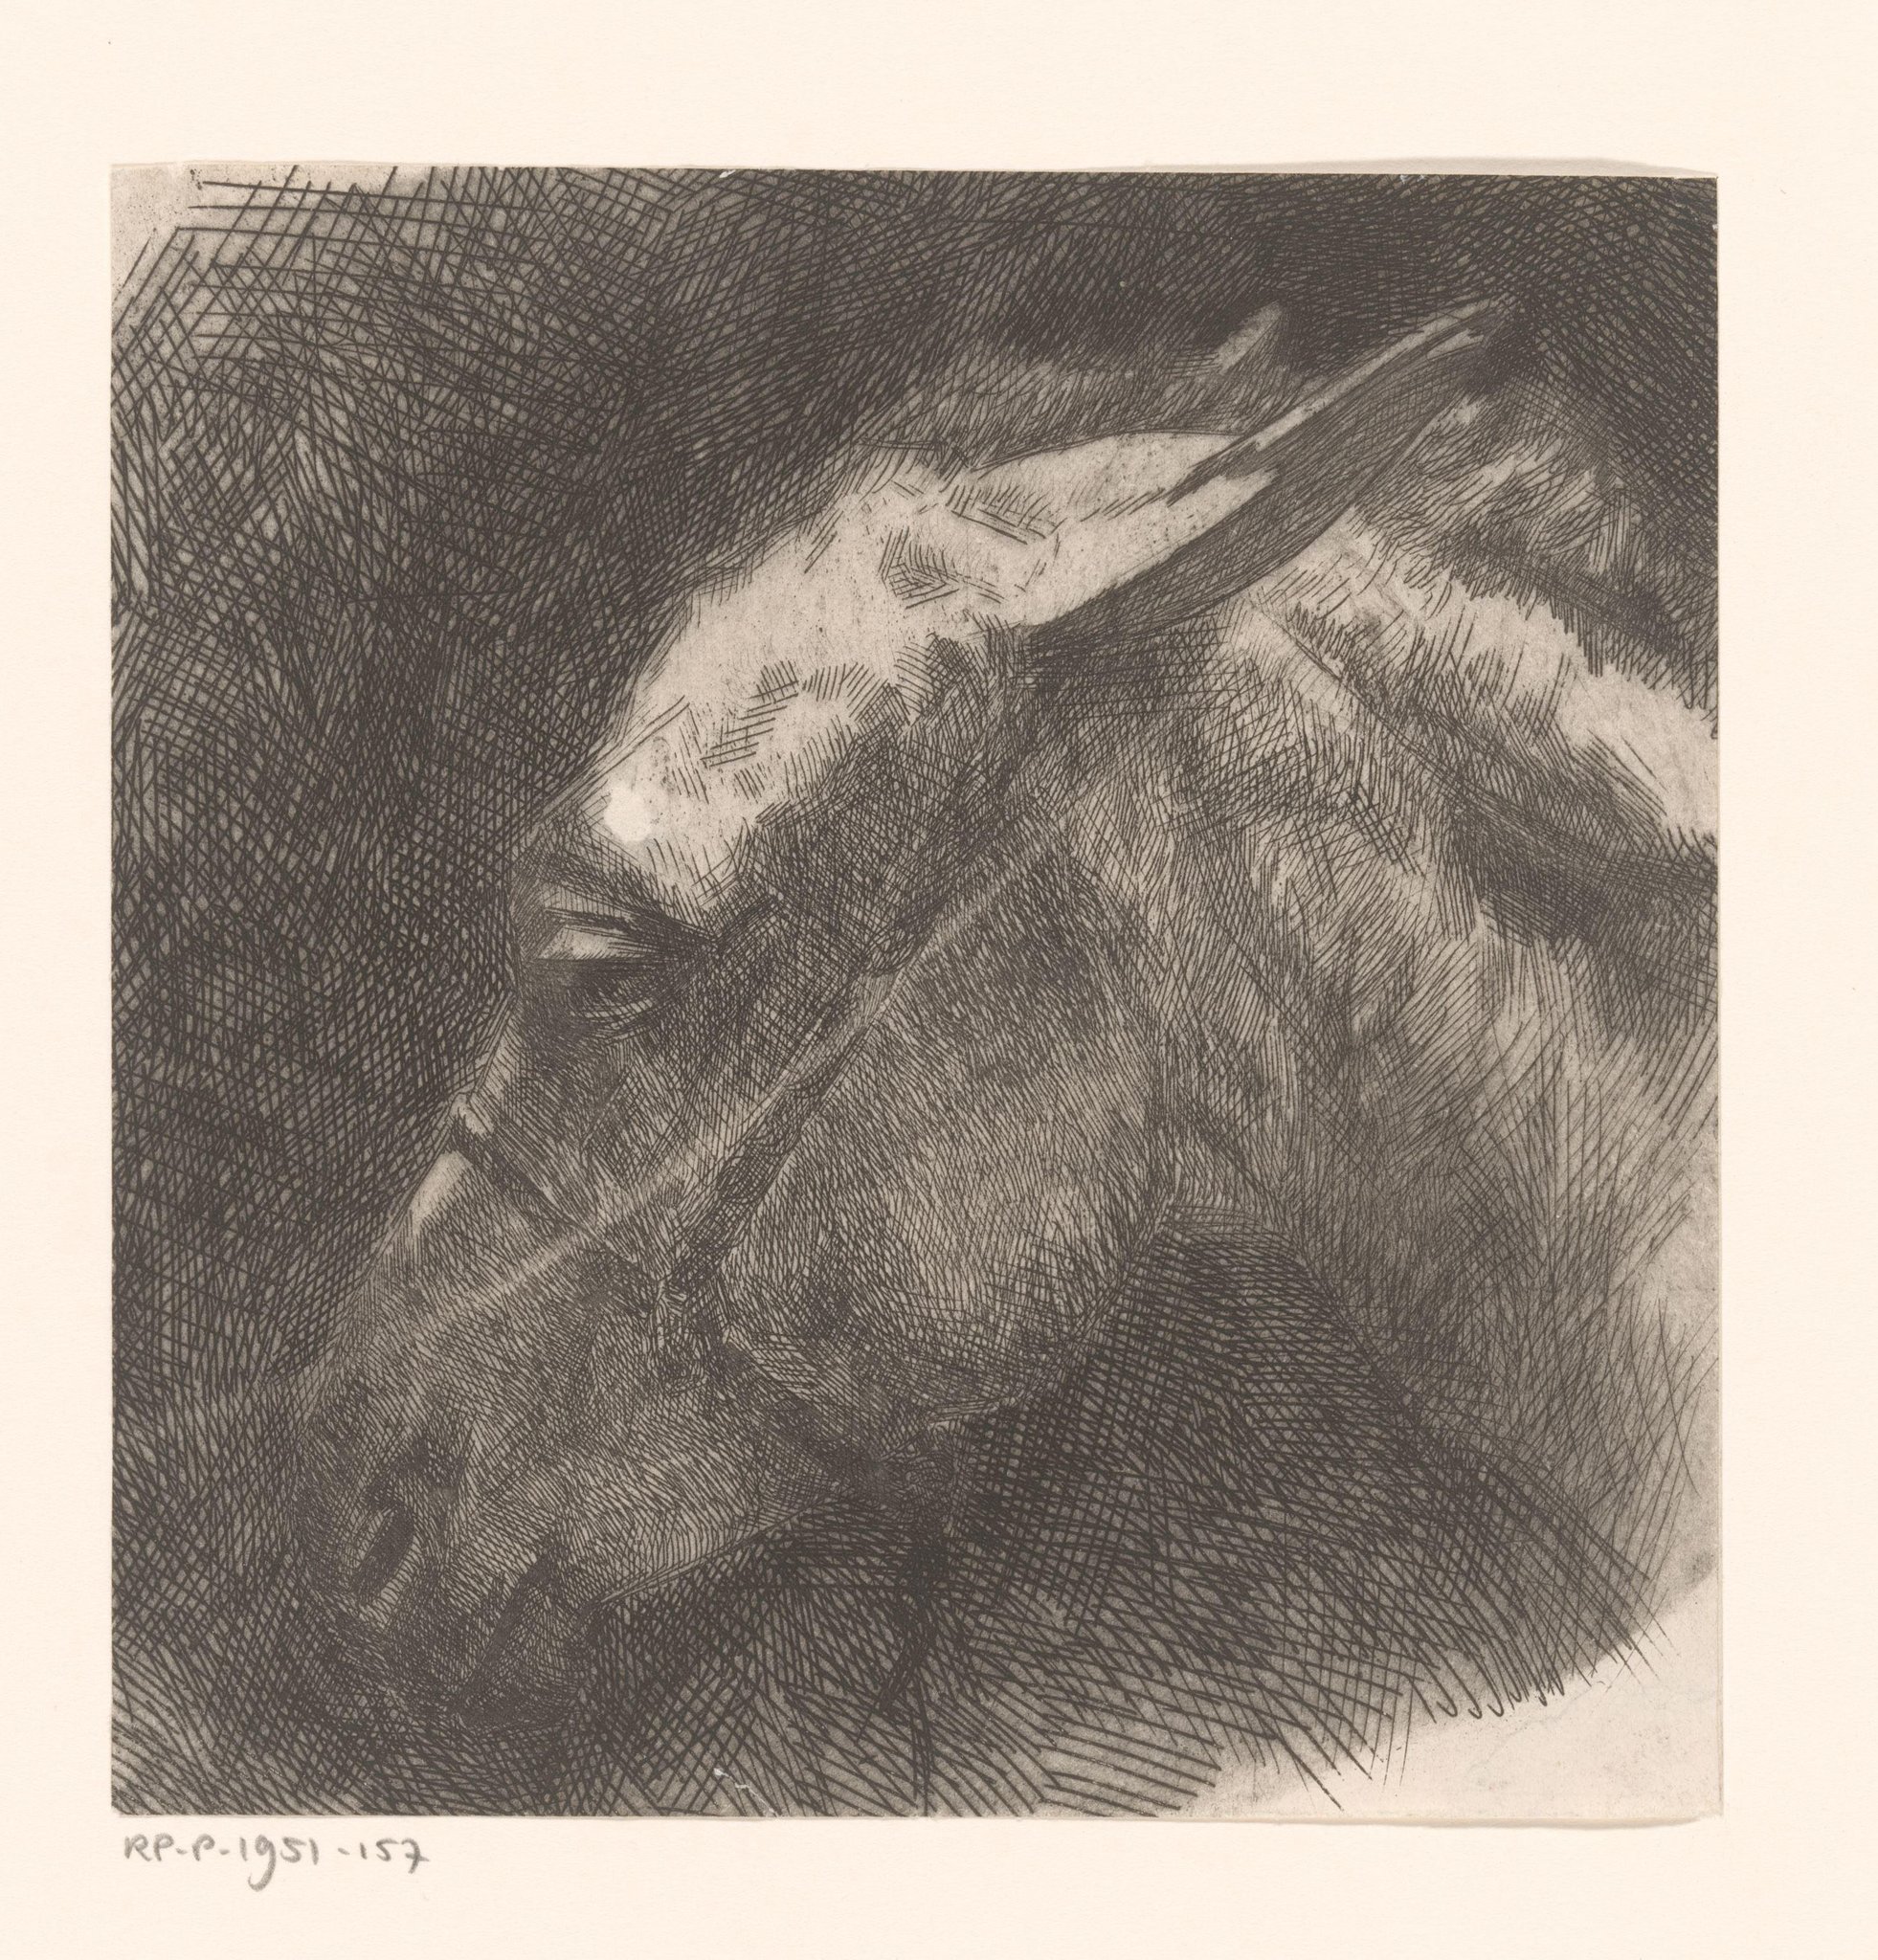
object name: print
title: Kop van een muilezel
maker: maurits van der valk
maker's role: draughtsman, print maker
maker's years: 1857-1935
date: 1867-1935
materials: paper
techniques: drypoint, etching, intaglio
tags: mule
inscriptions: collector's mark: Lugt 2228